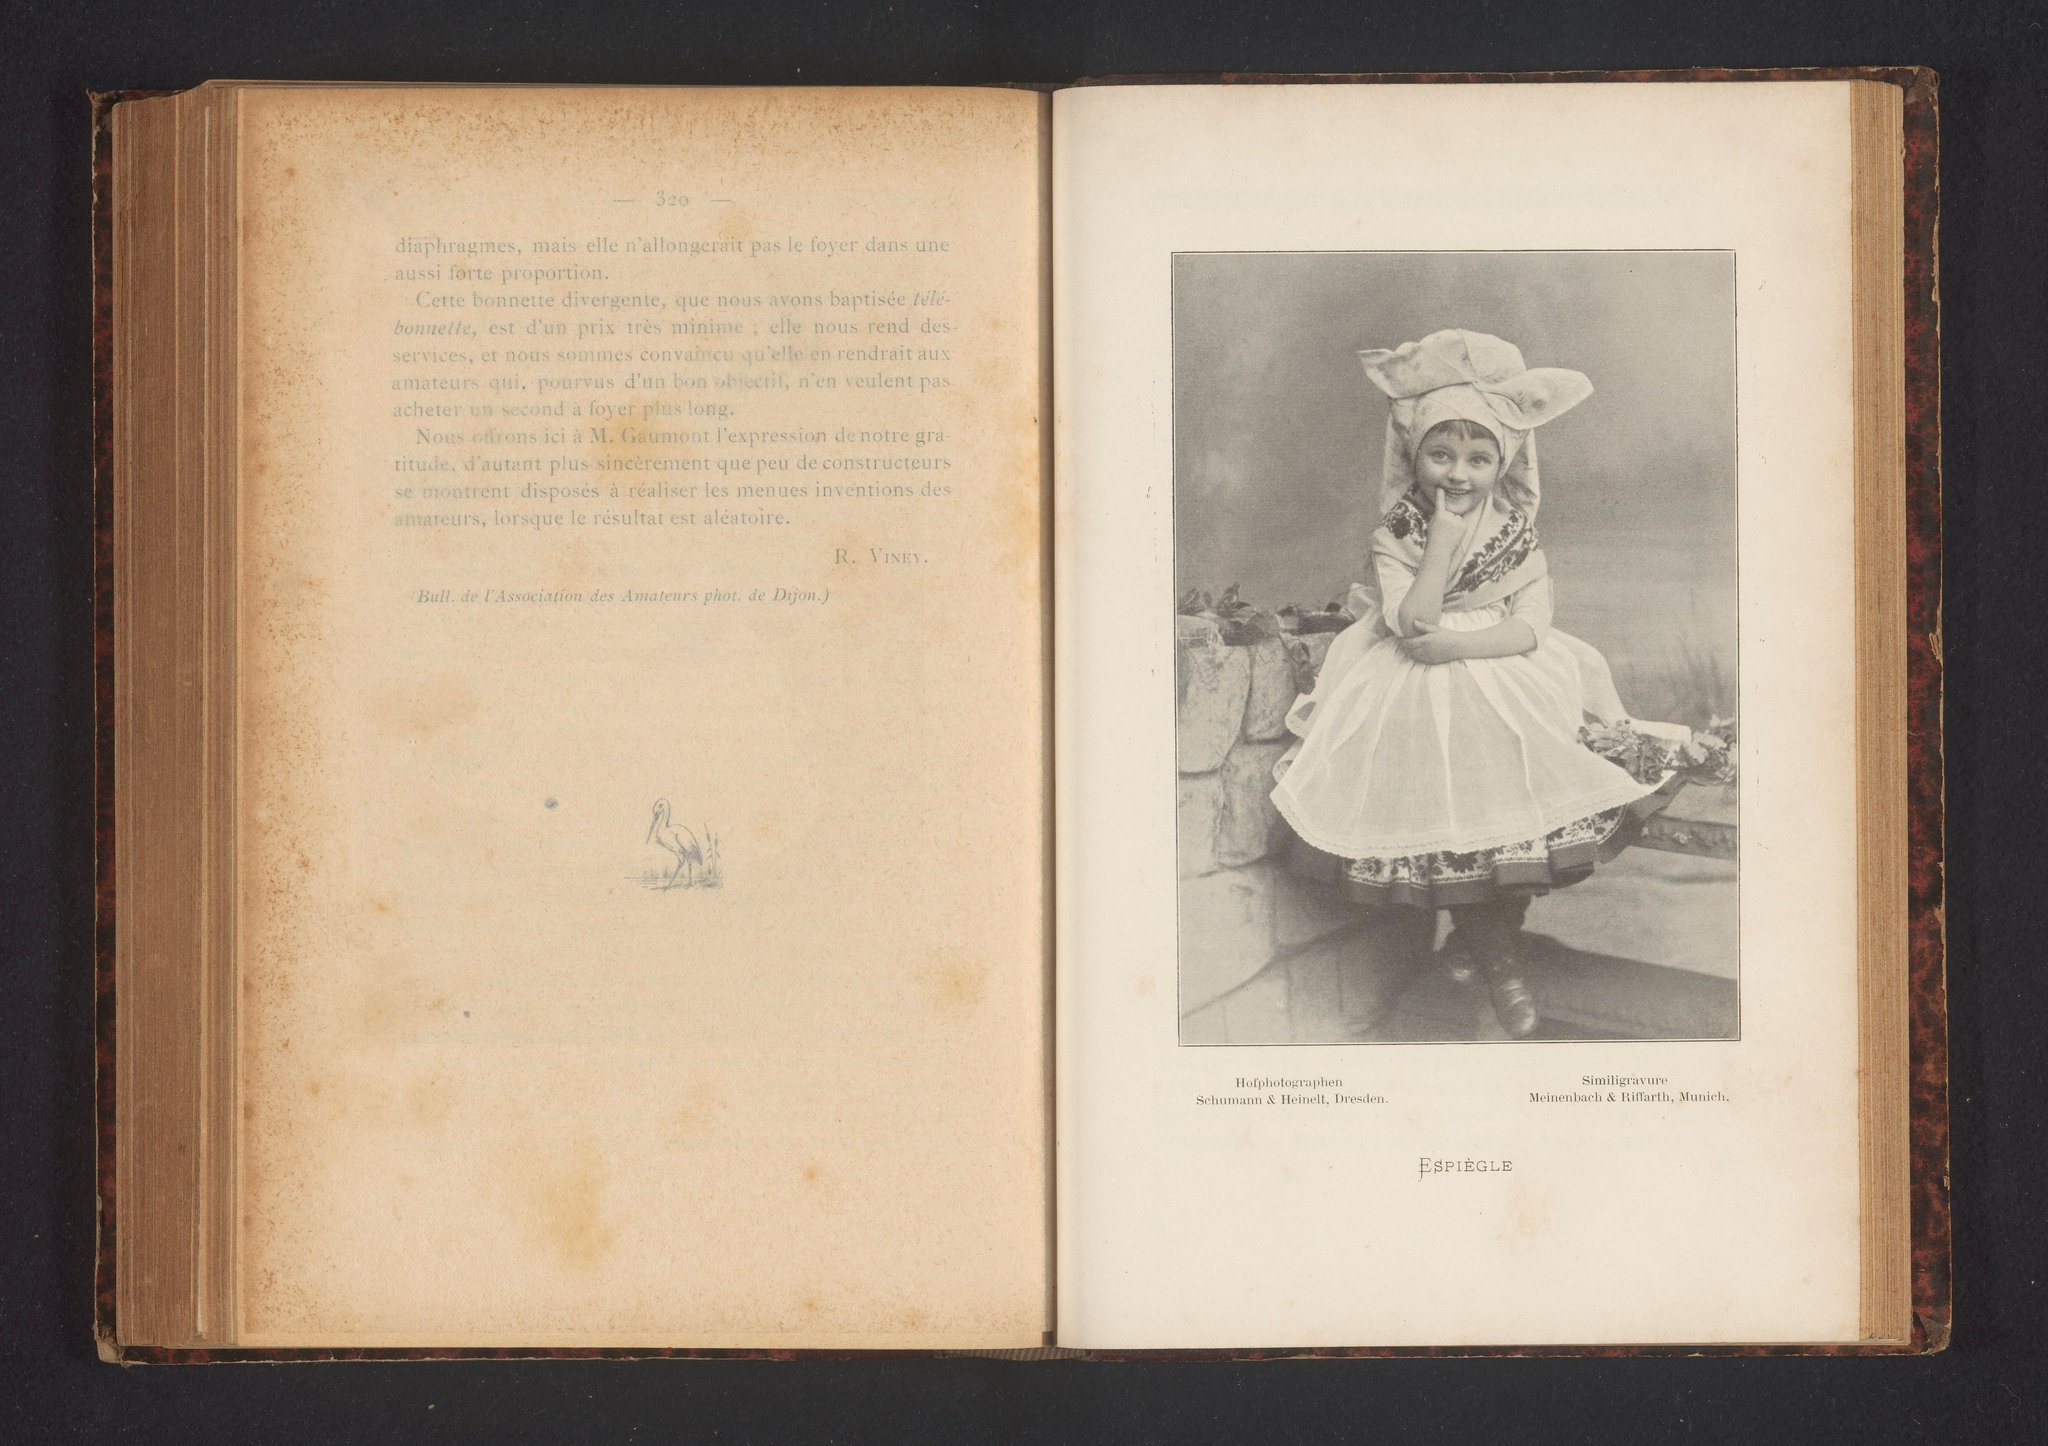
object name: page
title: Espiègle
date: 1891-1896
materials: paper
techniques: autotype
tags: historical persons not known by name - bb - woman, girl (child between toddler and youth)